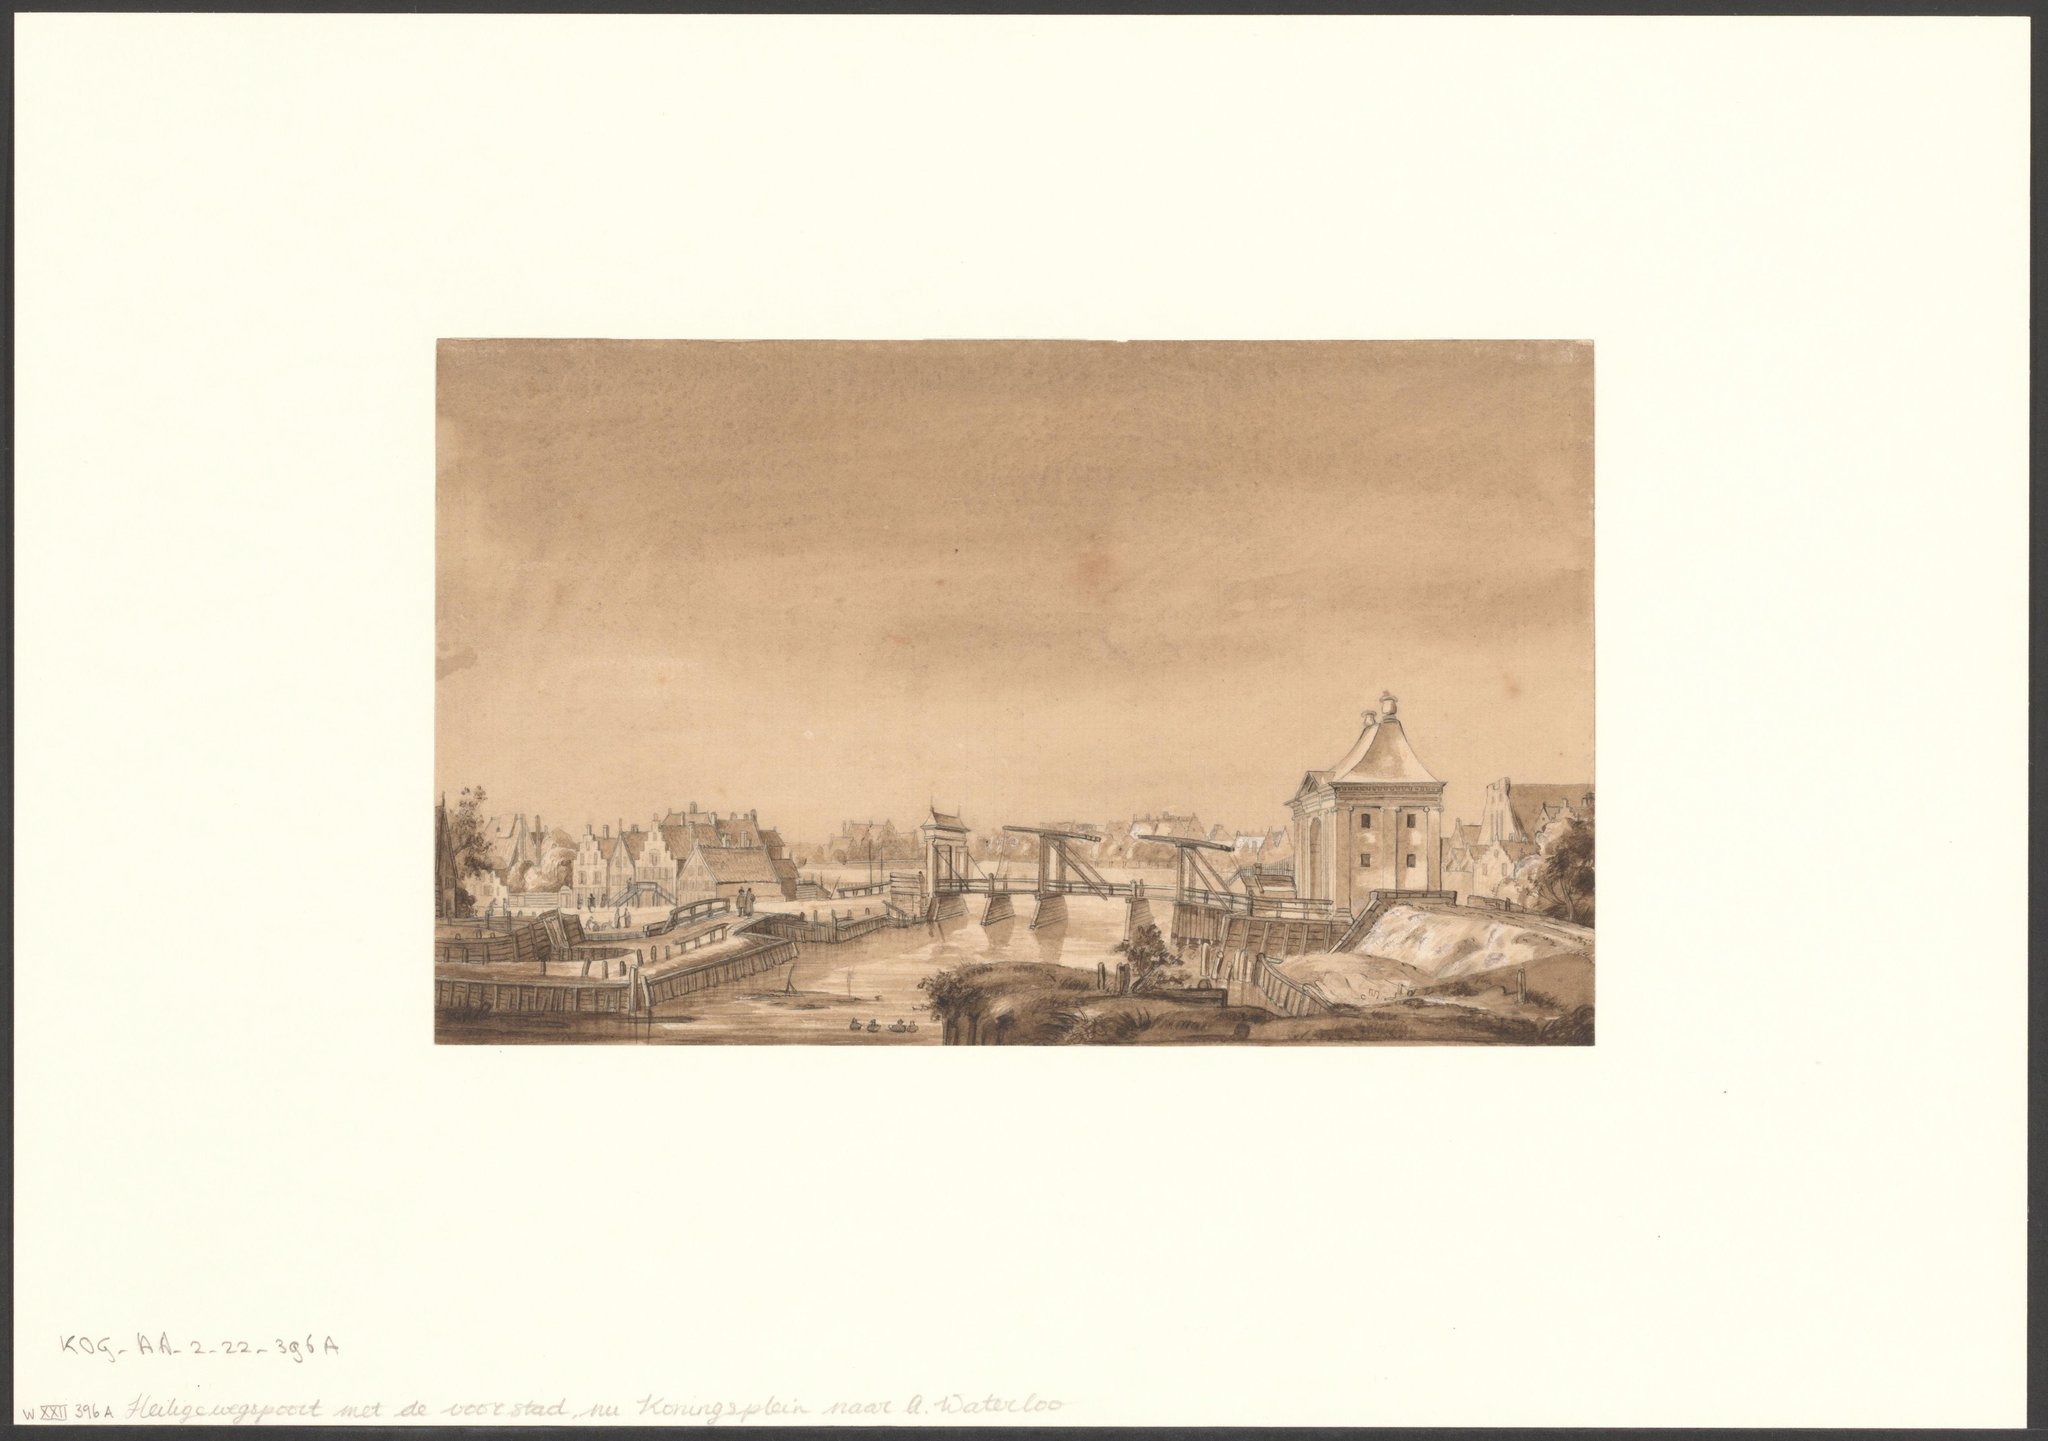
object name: drawing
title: Gezicht op de Heiligewegspoort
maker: Anonymous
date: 1637-1664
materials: ink, paper, pencil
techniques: brush, pen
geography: amsterdam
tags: city-view in general; 'veduta', canal, bridge in city across river, canal, etc., city-gate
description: Tekening binnen de Atlas Van Eck ingedeeld op wijknummer 22.